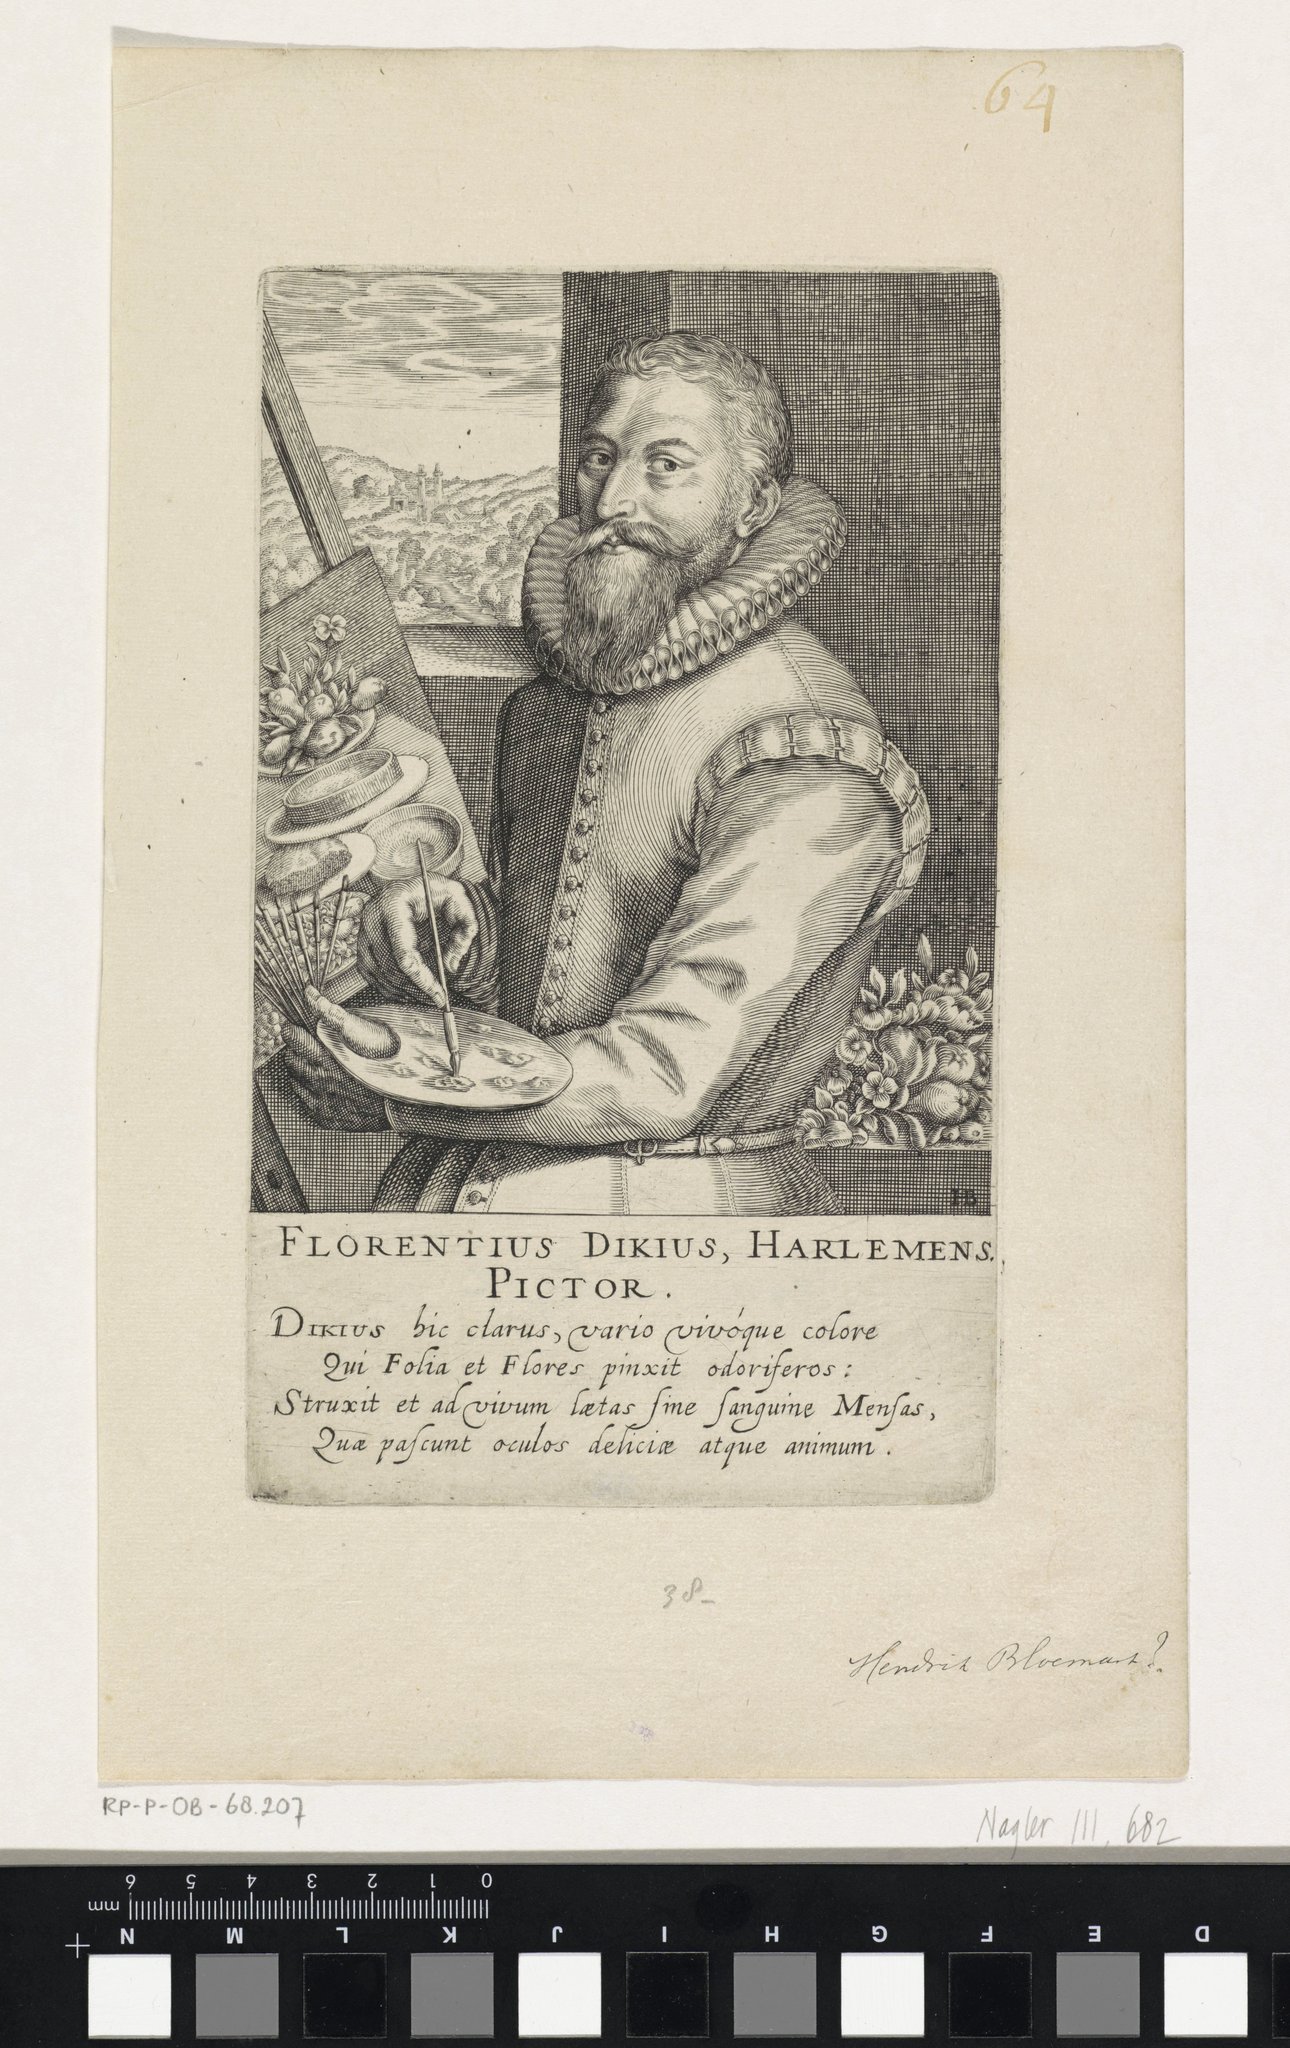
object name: print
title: Portret van Floris Claesz. van Dijck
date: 1600-1650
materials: paper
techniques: engraving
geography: northern netherlands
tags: haarlem, painter, floris claesz van dijck, portrait, self-portrait of painter (+ artist at work)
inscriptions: collector's mark: Lugt 2227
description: Portret van de Haarlemse schilder Floris Claesz. van Dijck met baard en plooikraag. Hij staat met een palet en penselen bij een ezel met een stilleven. Achter hem een bosgezicht. Onder de voorstelling de naam en functie van de geportretteerde en een vierregelig lofdicht in het Latijn.